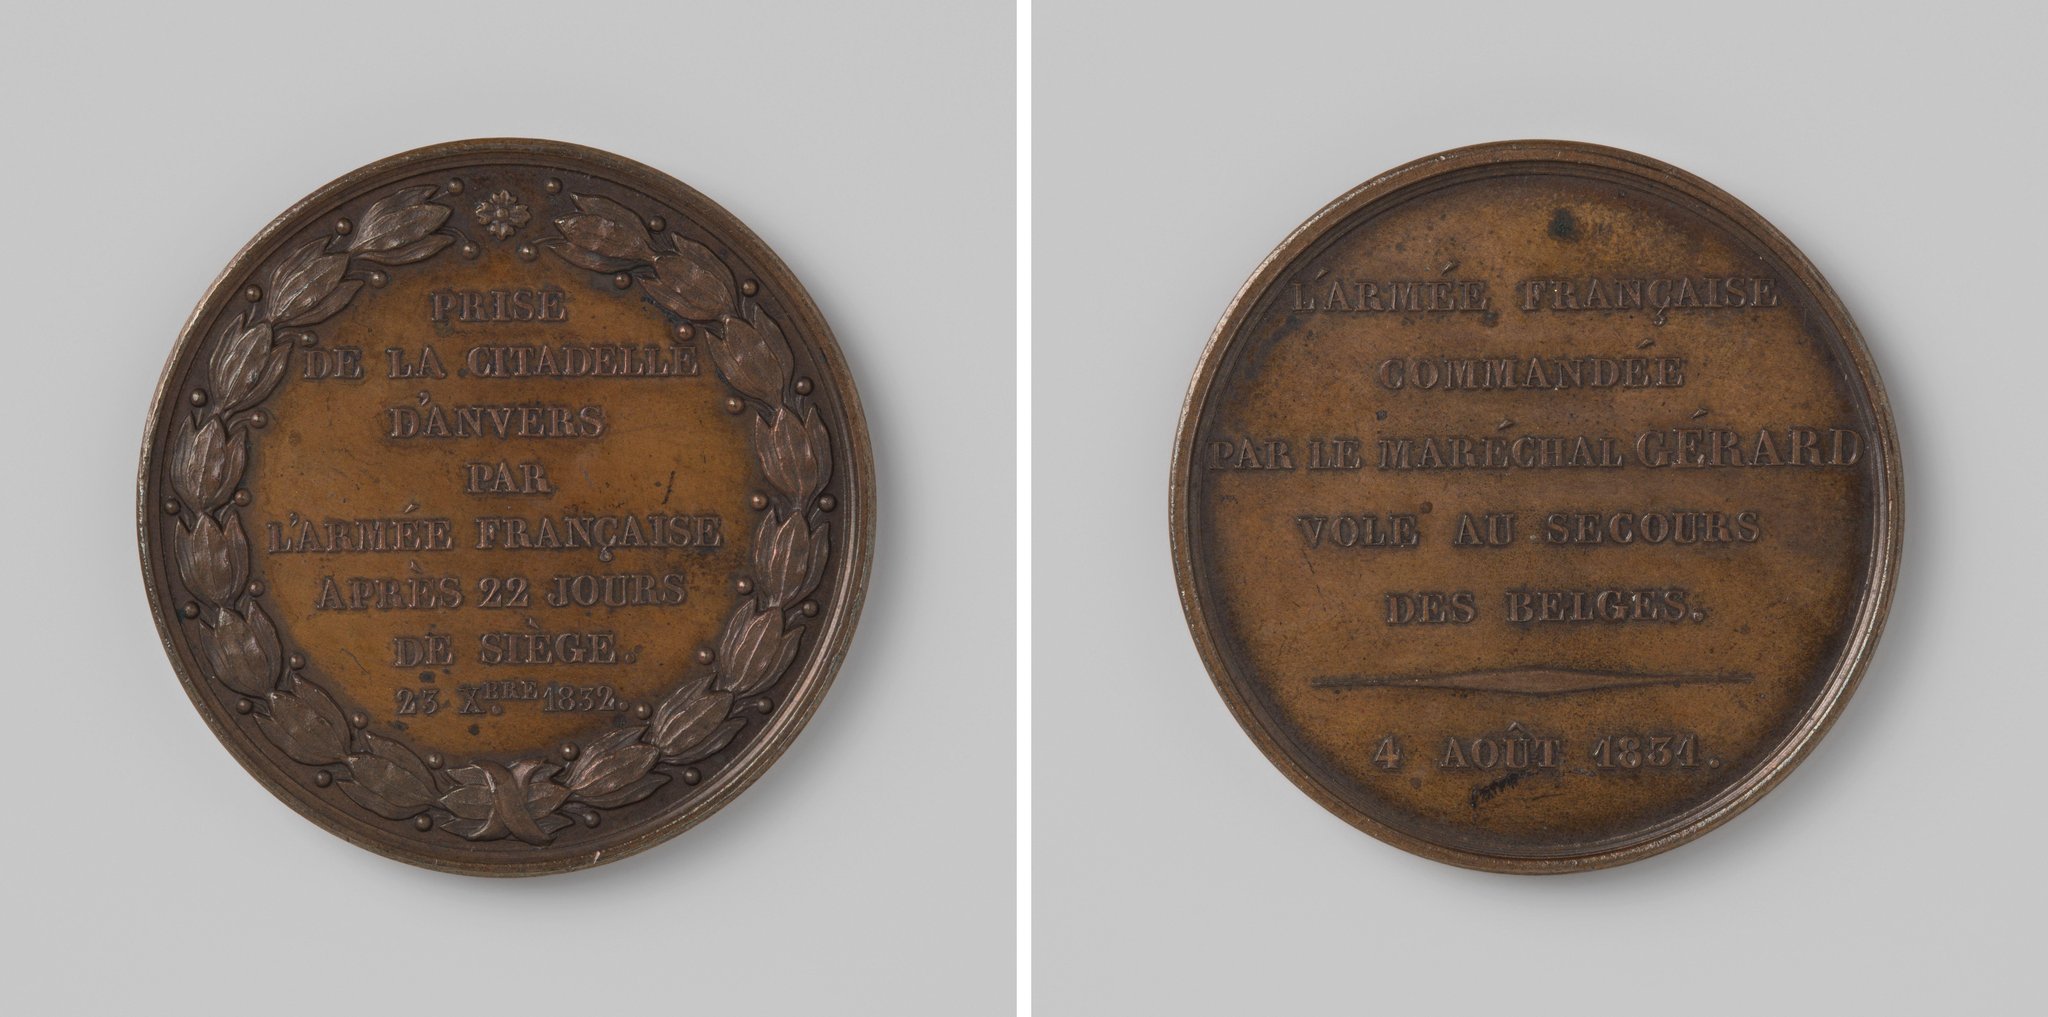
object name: history medal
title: Franse steun tijdens de Tiendaagse veldtocht en bij de verovering van de citadel van Antwerpen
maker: m. borrel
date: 1832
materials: bronze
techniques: striking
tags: generaal, étienne maurice gérard, citadel van antwerpen (19e eeuw), strijd om de citadel van antwerpen (1832), belgische revolutie, tiendaagse veldtocht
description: Bronzen penning. Voorzijde: opschrift in krans van olijftakken. Keerzijde: opschrift.